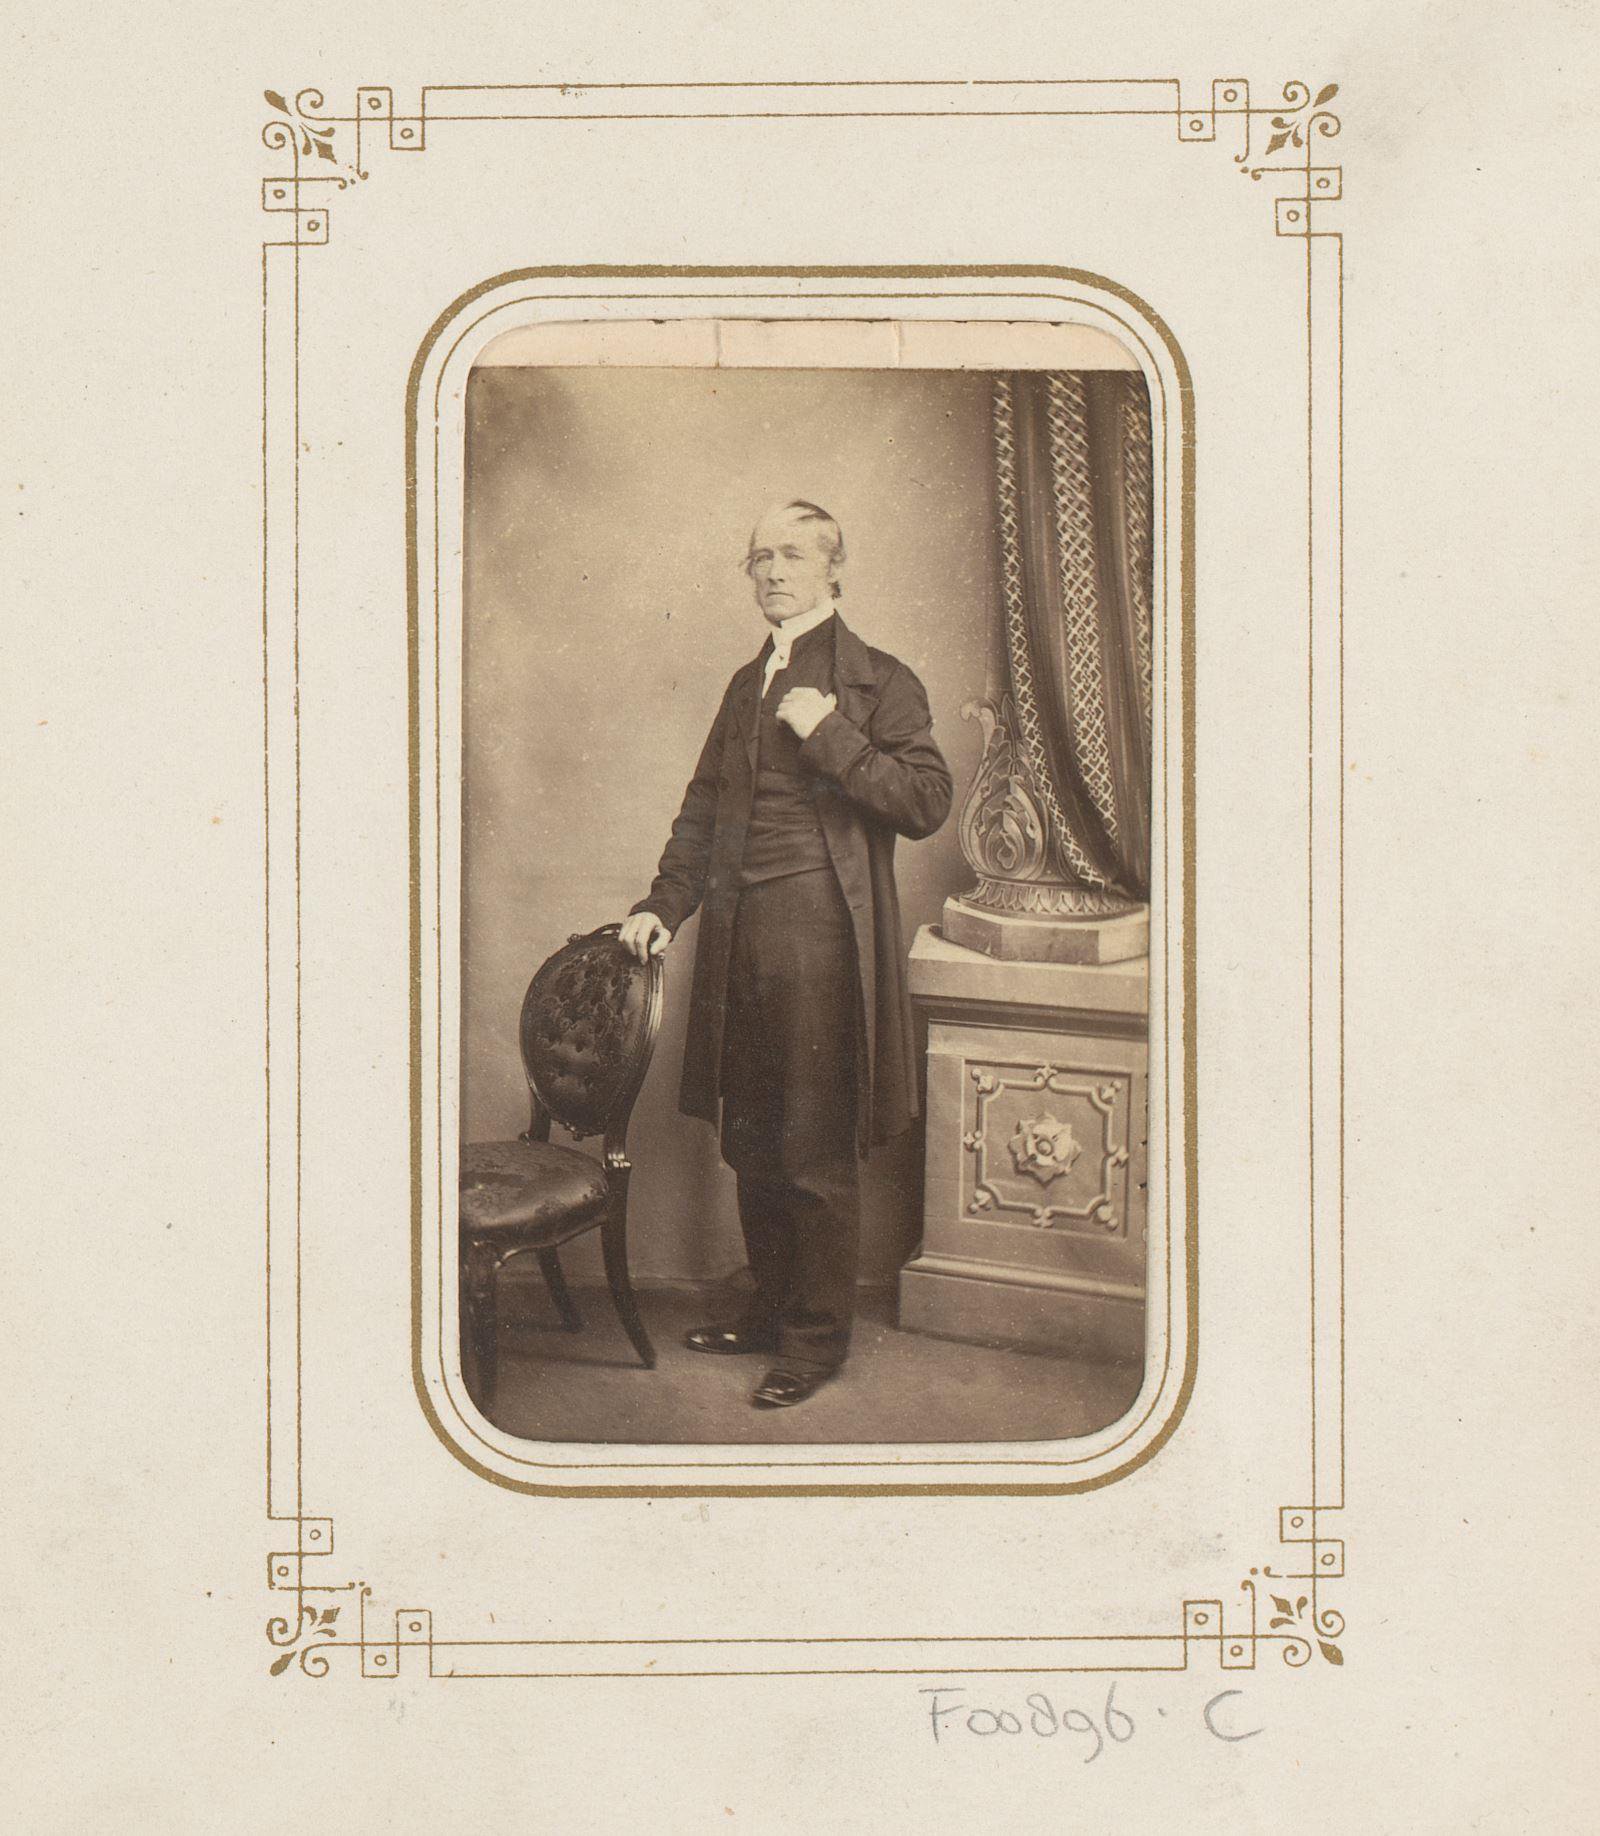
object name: album leaf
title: Portret van een staande man bij een stoel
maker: Anonymous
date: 1860-1890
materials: cardboard, photographic support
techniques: albumen print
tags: standing figure, adult man, historical persons